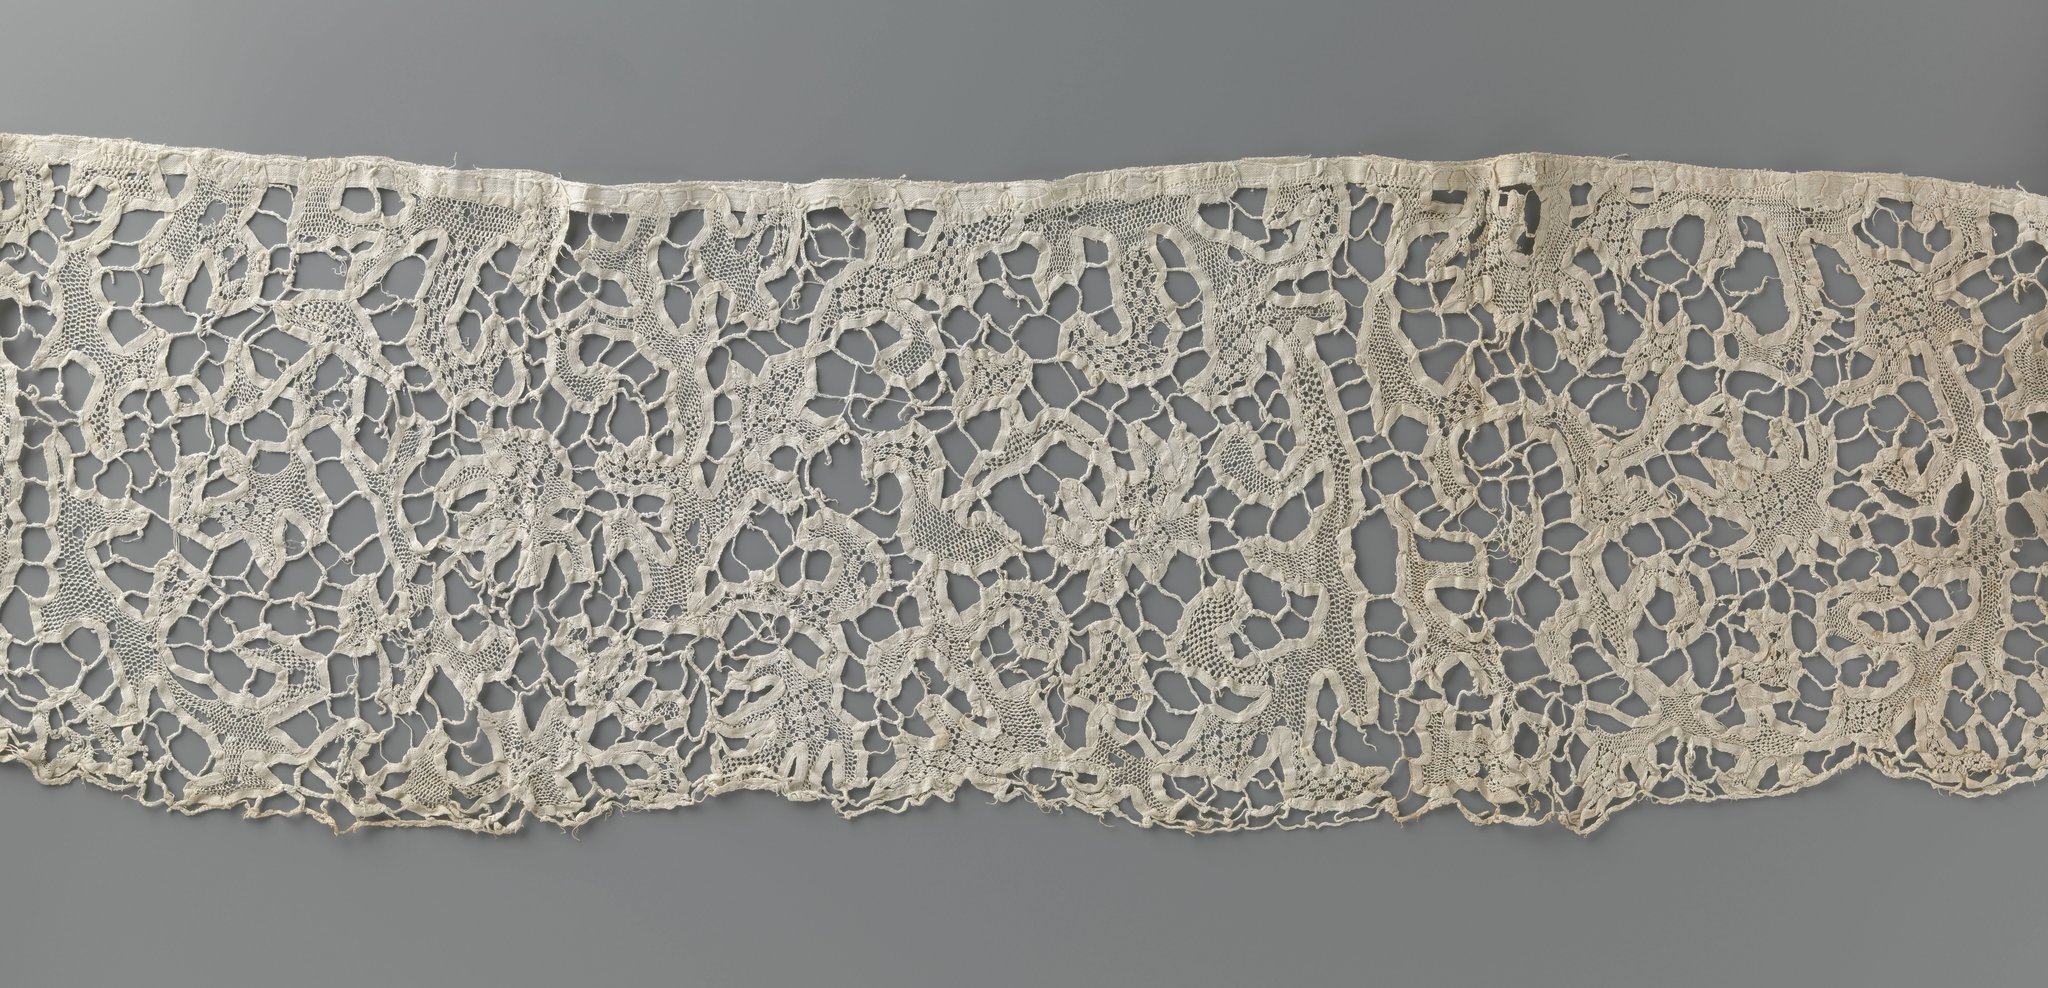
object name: albestrook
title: Strook gemengde kant voor een superplie met lelies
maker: Anonymous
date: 1640-1660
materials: linen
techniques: lace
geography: burano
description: Strook naturelkleurig naaldkant: Venetiaanse lintjeskant. De gesloten, rondlopende strook is bestemd voor een superplie en heeft een patroon van voluutranken, wingerdbladeren en lelies op een open grond met gefestonneerde spijlen. De contouren van het patroon worden gevormd door een geweven lint. Binnen de contouren verschillende siergronden. De bovenzijde is afgezet met een geweven rand. De onderzijde is afgezet met een rechte rand.